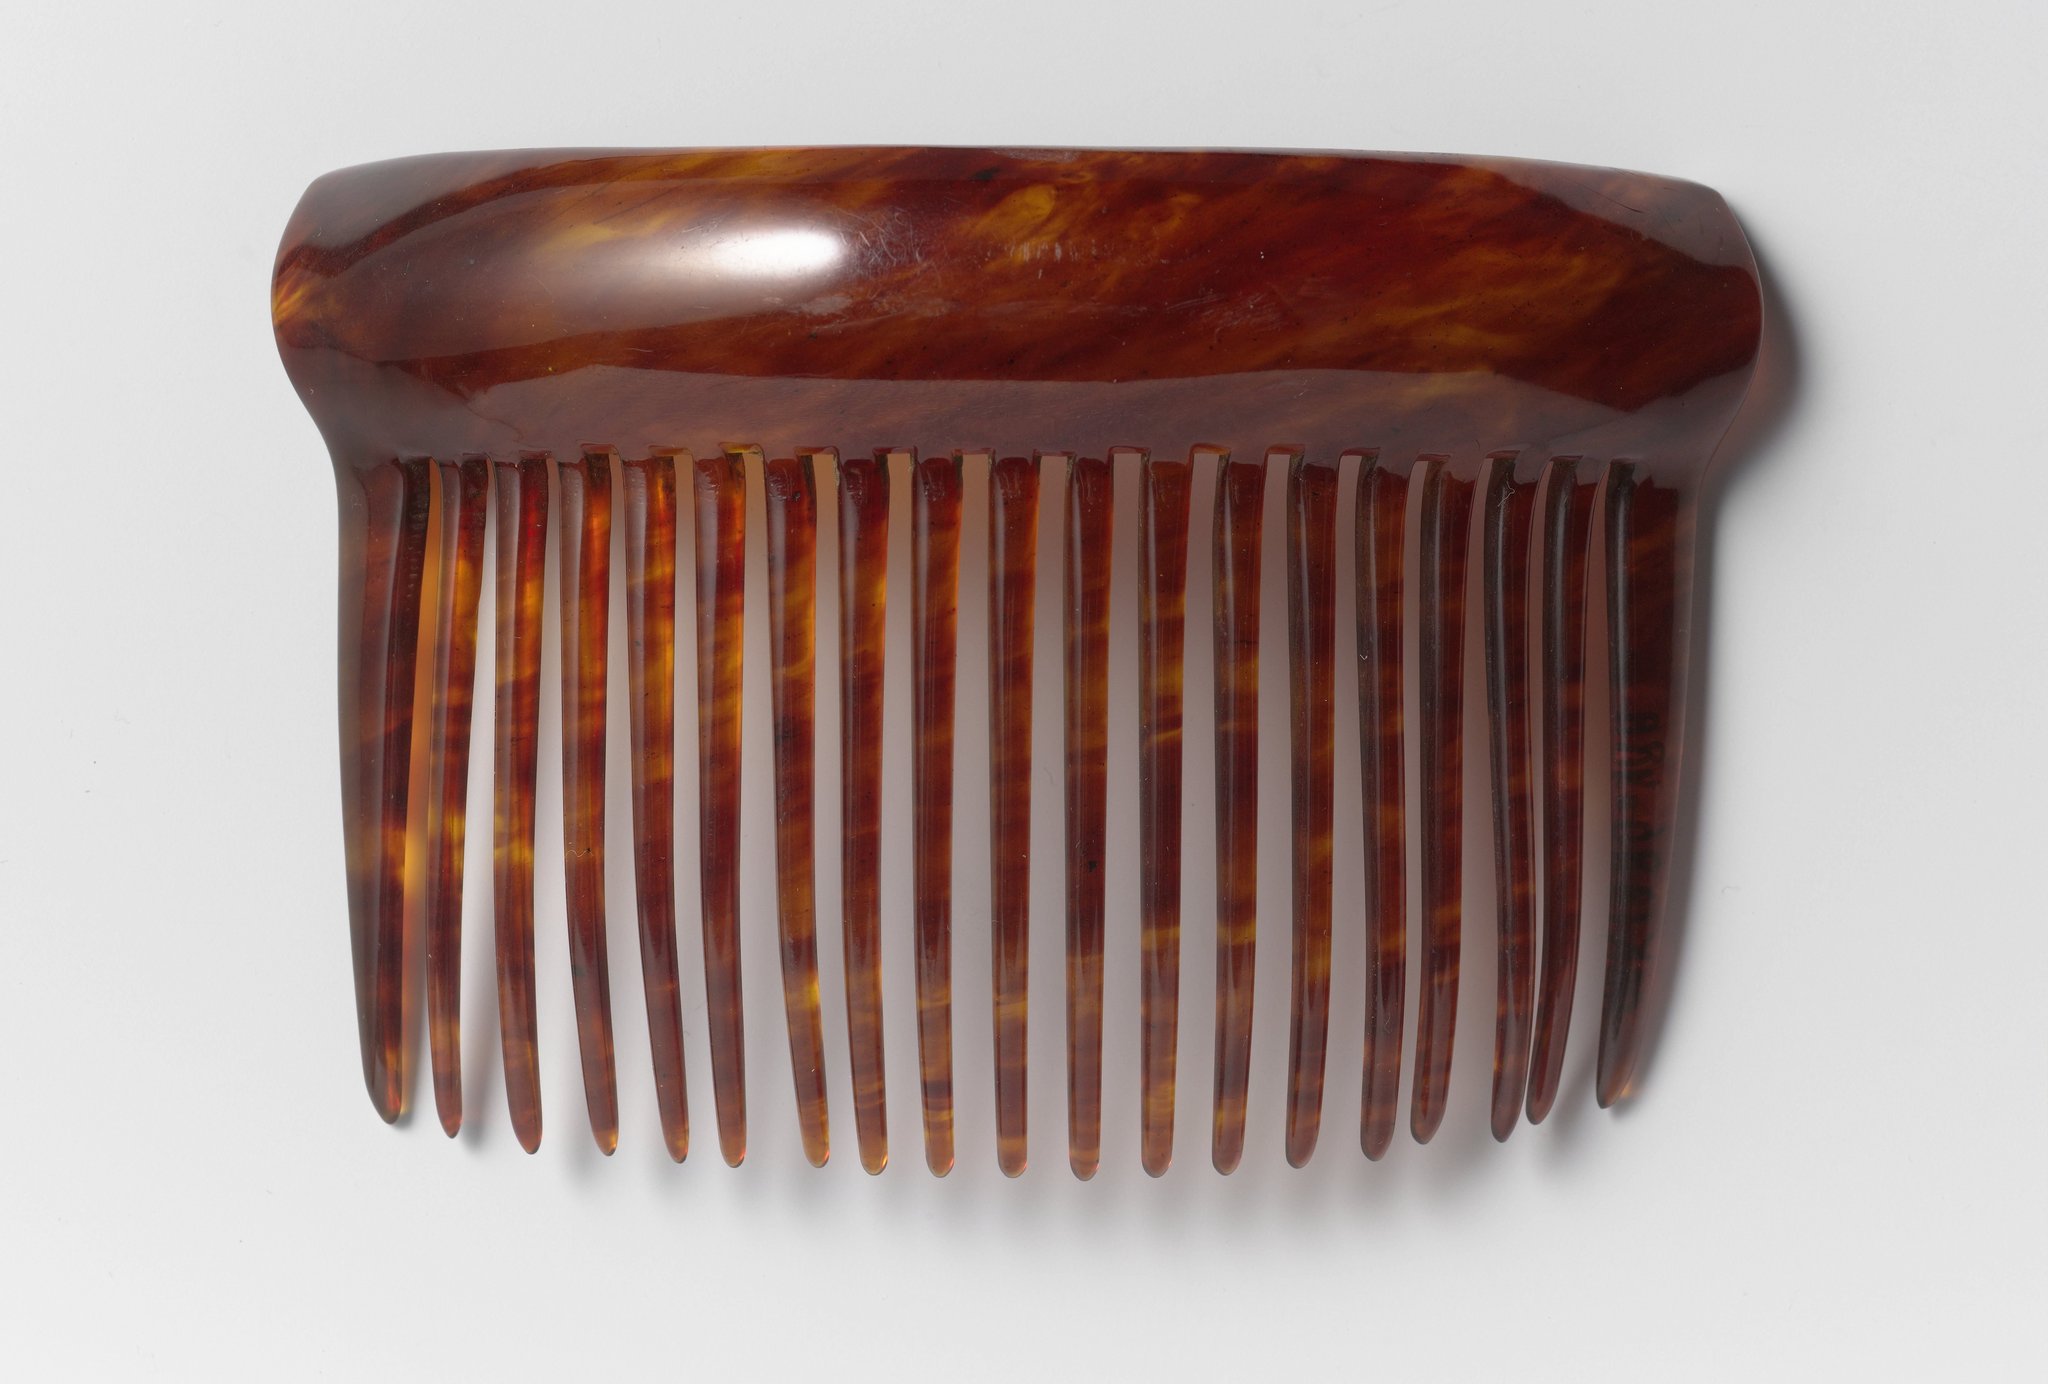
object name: comb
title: Haarkam van imitatie schildpad met opbollende, onversierde rug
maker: Anonymous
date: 1900-1949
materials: celluloid, plastic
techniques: filing, polish, pressing, sawing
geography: netherlands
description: Haarkam van imitatie schildpad met opbollende, onversierde rug, 19 tanden.